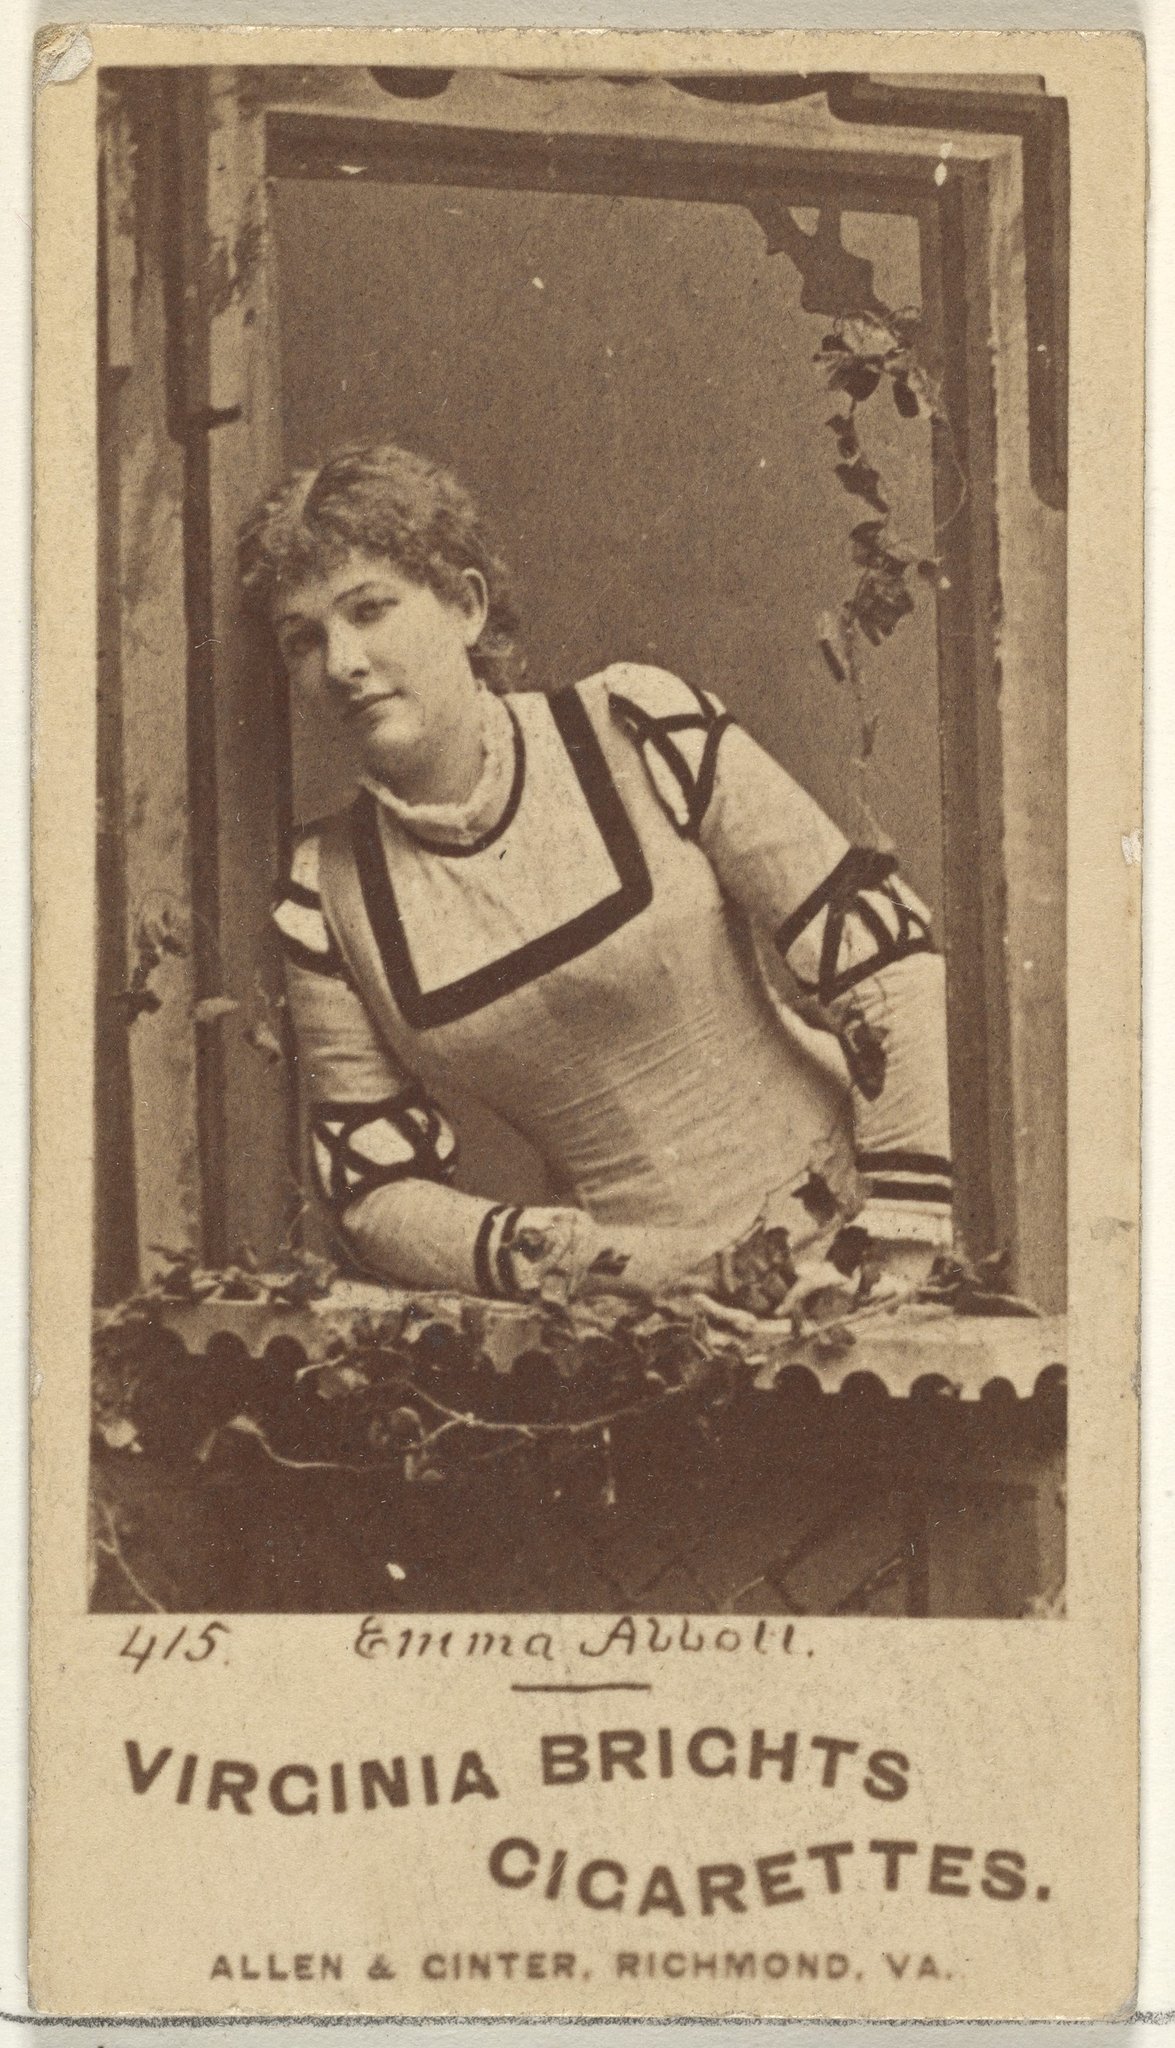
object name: photograph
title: Card 415, Emma Abbott, from the Actors and Actresses series (N45, Type 1) for Virginia Brights Cigarettes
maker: allen & ginter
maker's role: publisher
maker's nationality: american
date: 1888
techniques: albumen silver print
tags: portraits,women,actresses